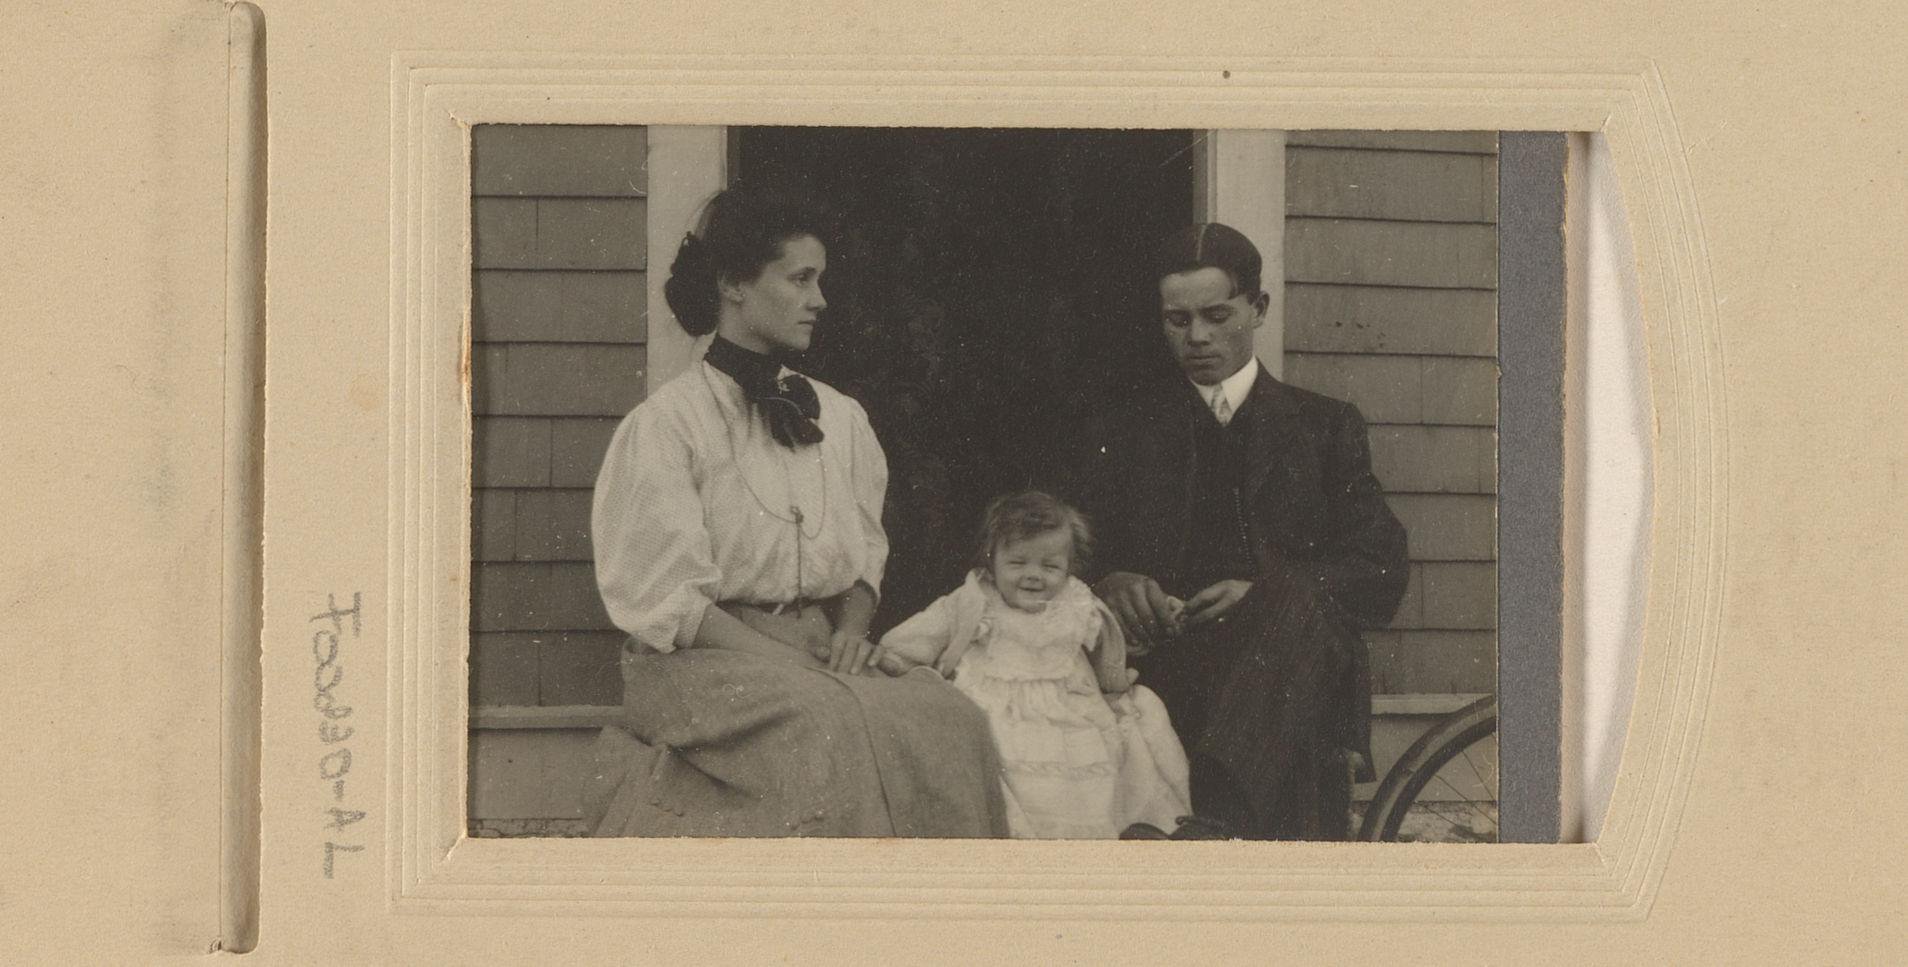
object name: album leaf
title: Portret van een man, vrouw en kind voor houten huis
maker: Anonymous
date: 1907-1910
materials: cardboard, photographic support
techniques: gelatin silver print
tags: parents with their children, historical persons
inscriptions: annotation: ‘Oct 1907’